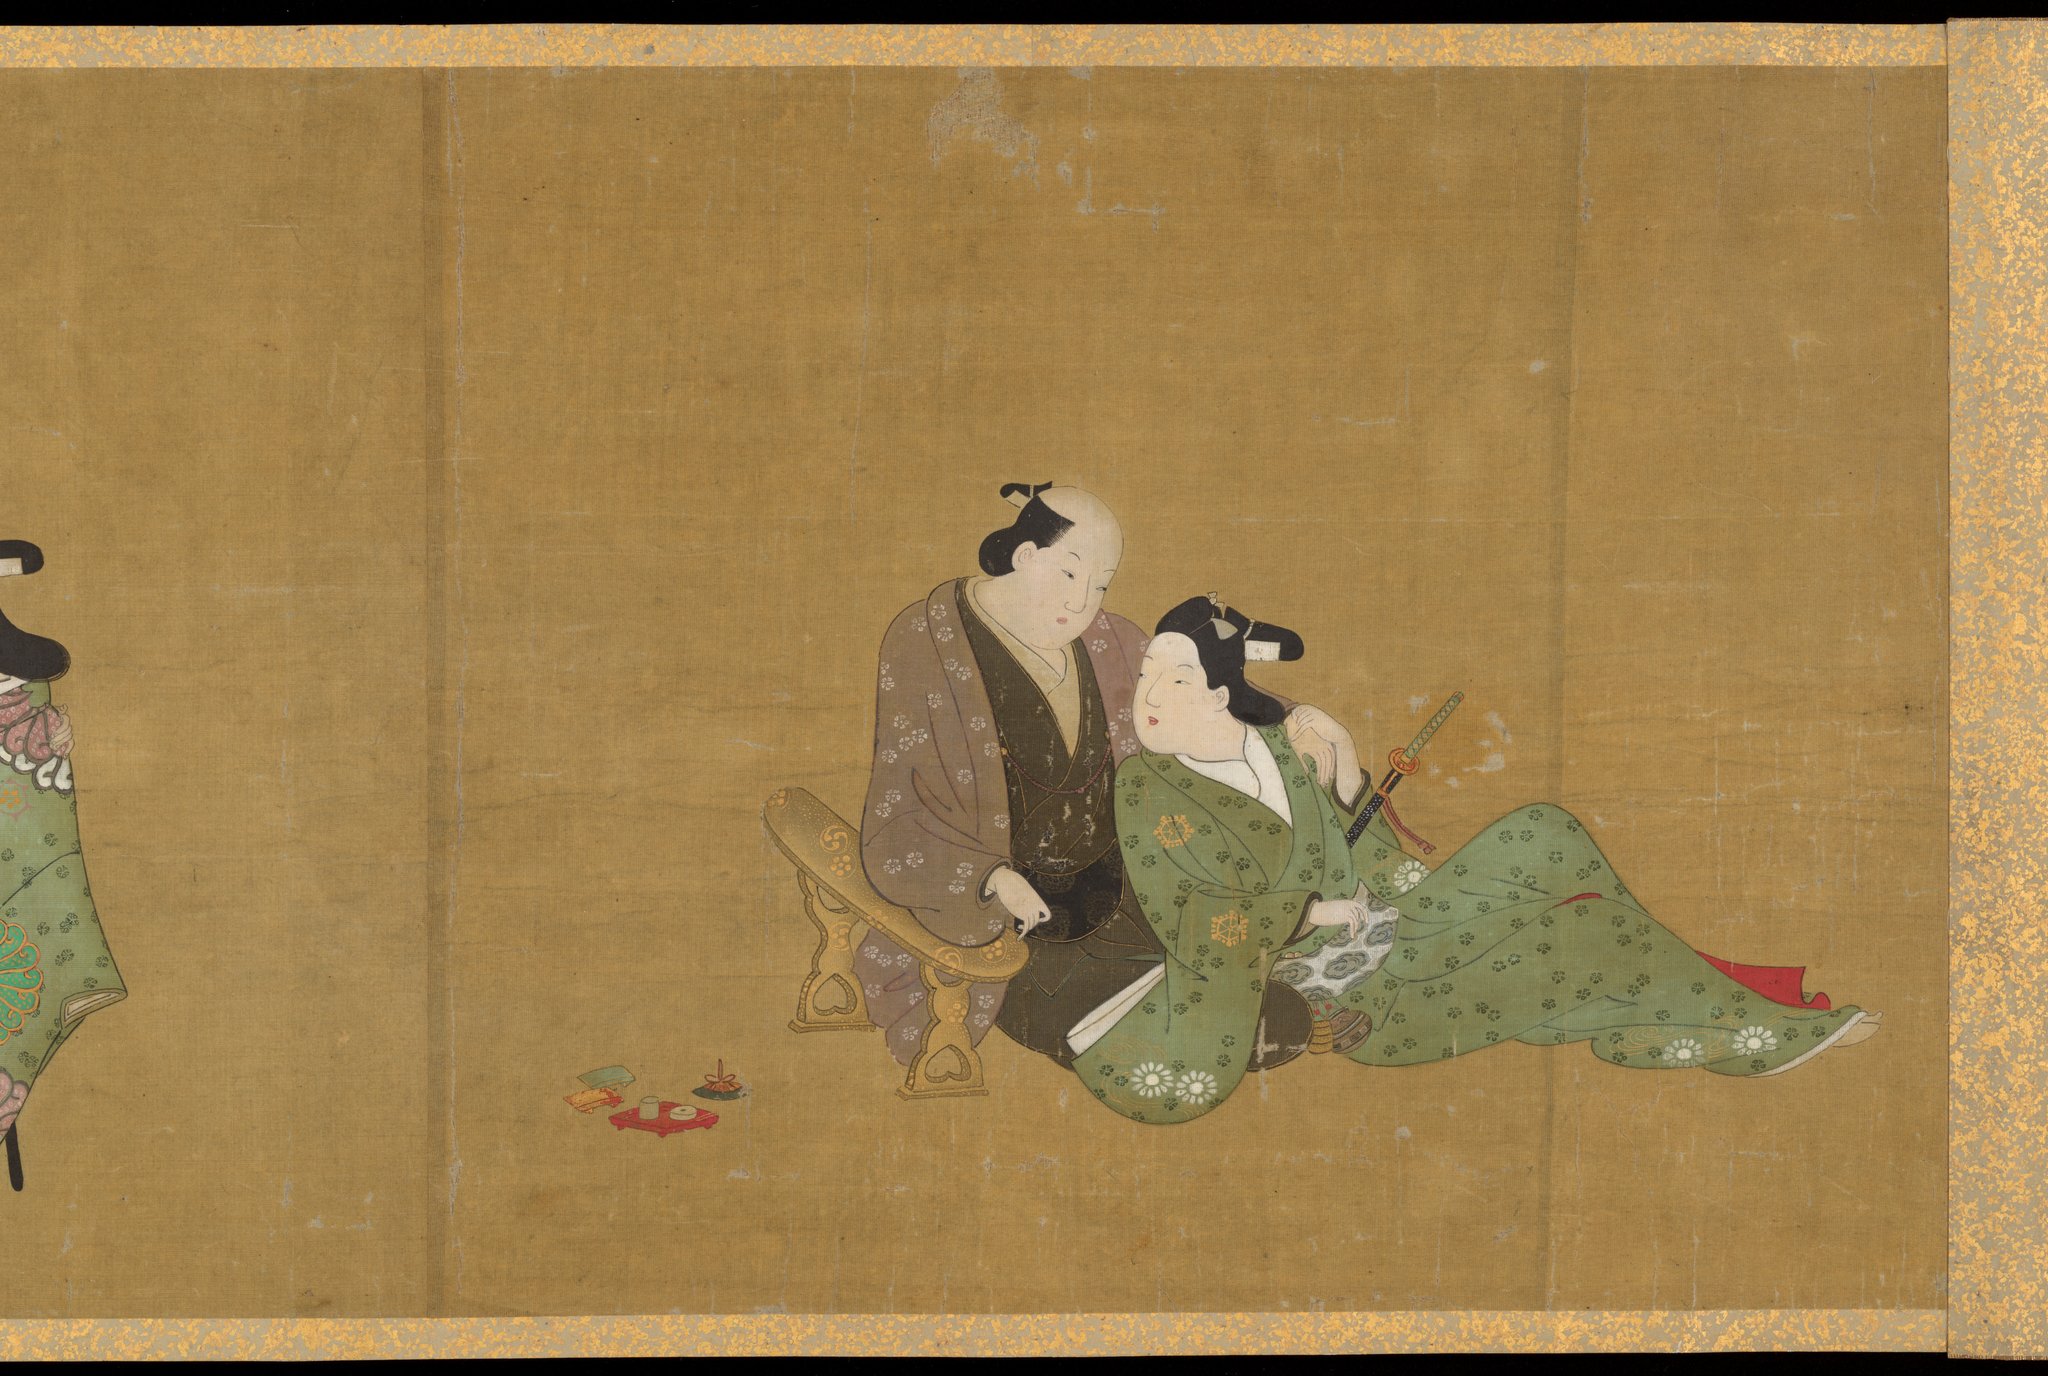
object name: handscroll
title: Handscroll of Ten Homoerotic (Nanshoku) Scenes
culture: japanese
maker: miyagawa chōshun 宮川長春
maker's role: artist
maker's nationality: japanese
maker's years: 1683-1753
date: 1701-1733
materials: ink, silk